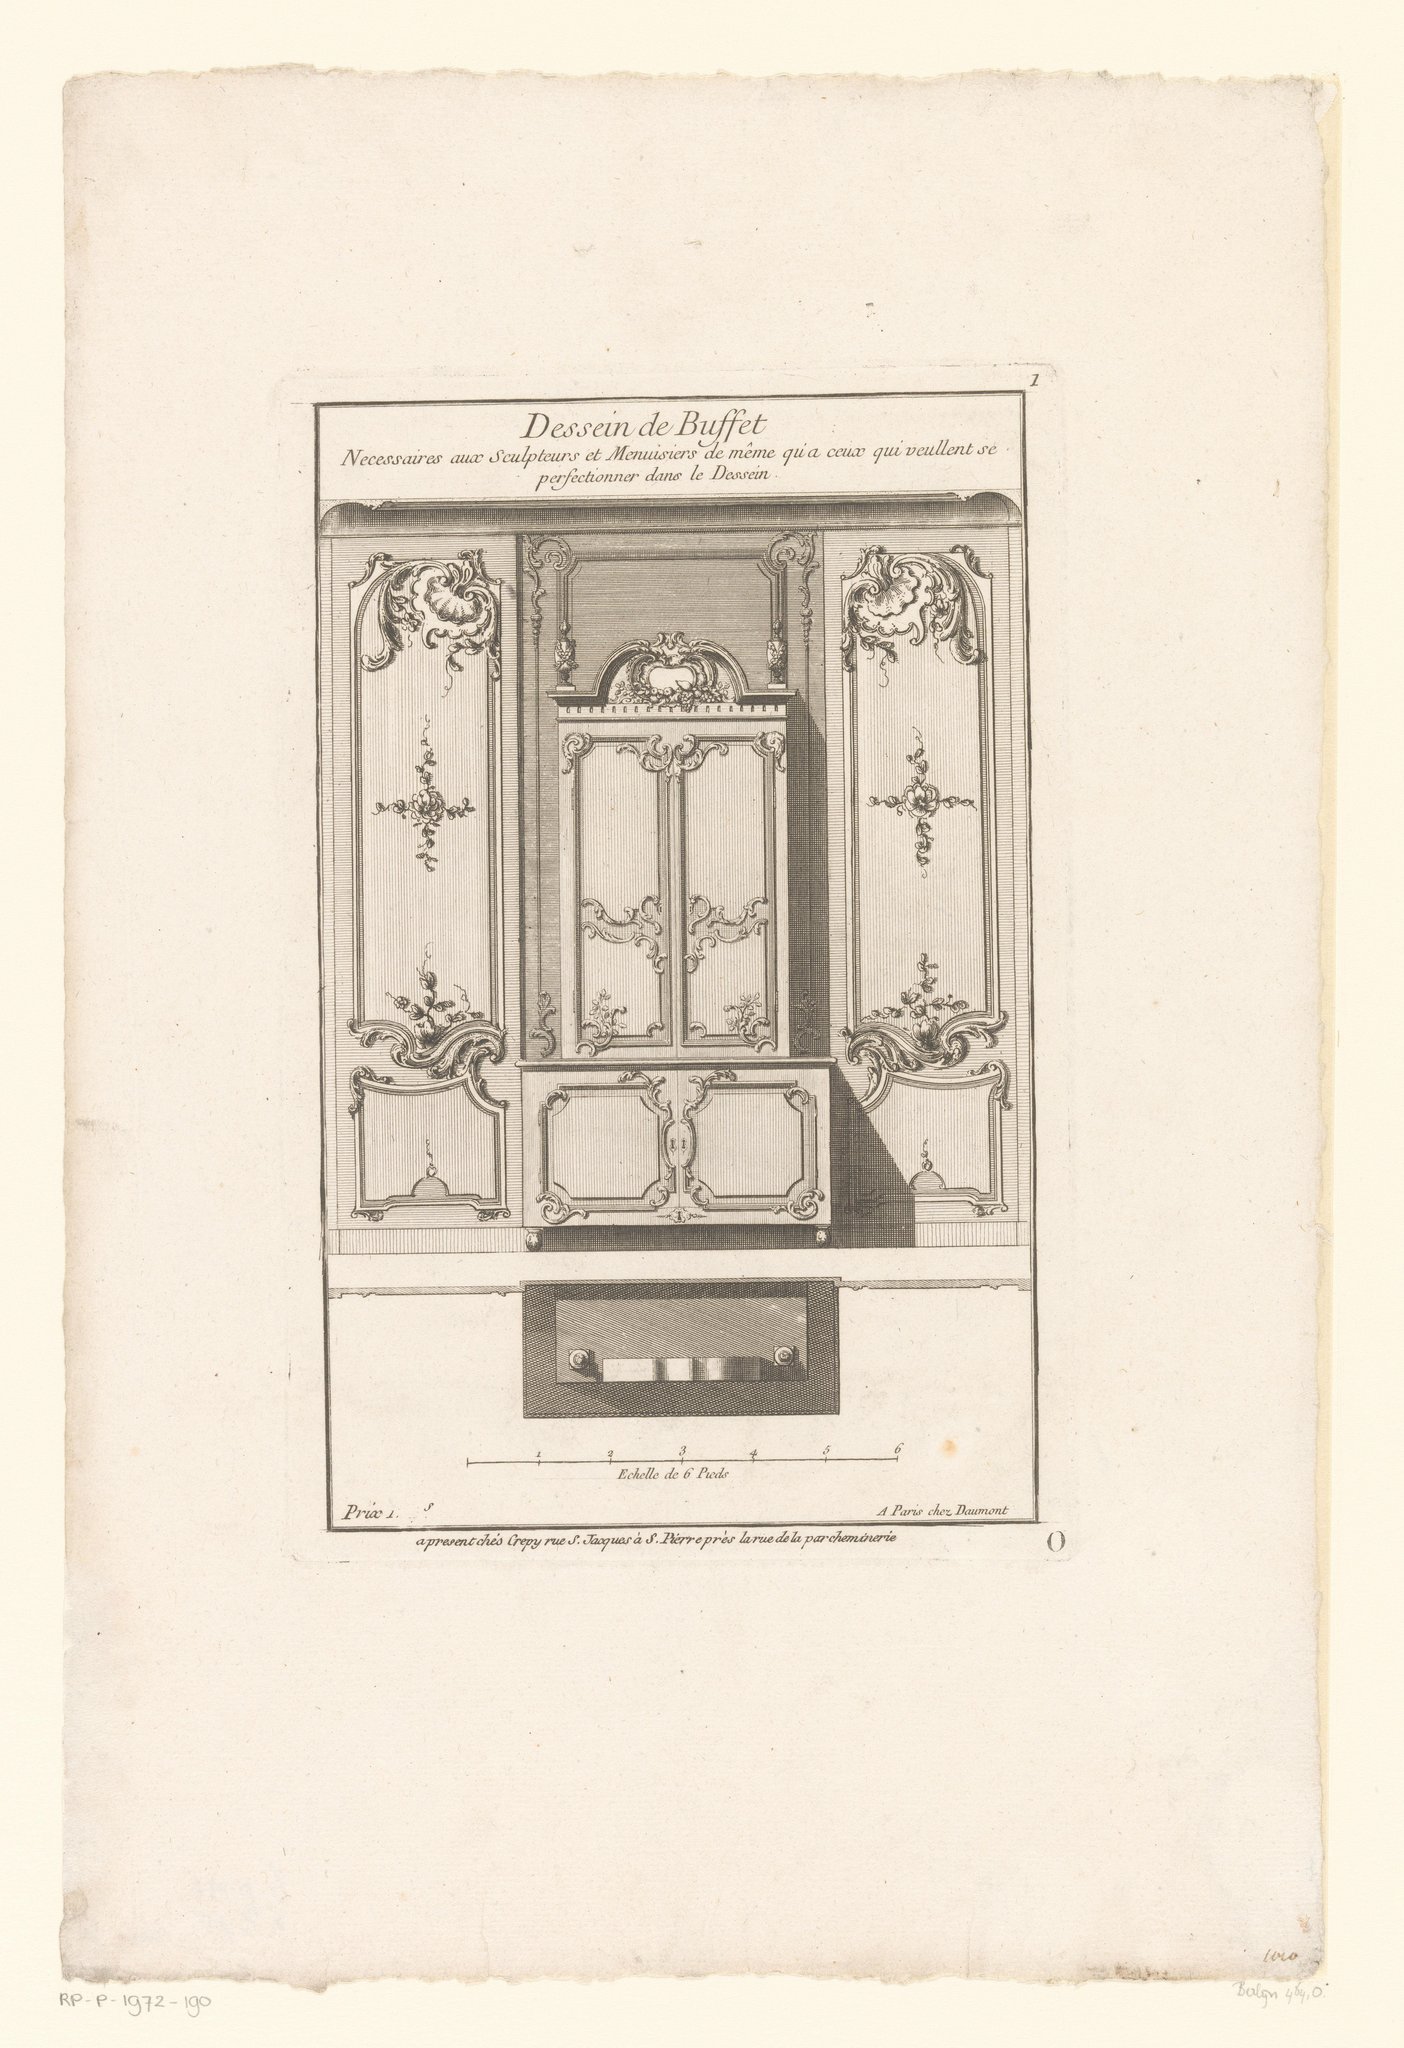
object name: ornament print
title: Dessein de Buffet (...)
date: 1745-1775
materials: paper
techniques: engraving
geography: paris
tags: furniture for storage, panelling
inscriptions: collector's mark: Lugt 2760, collector's mark: Lugt 2228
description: Vooraanzicht en plattegrond van een buffetkast met rocaille ornamenten. De kast staat tegen een wand met rocaille panelen.